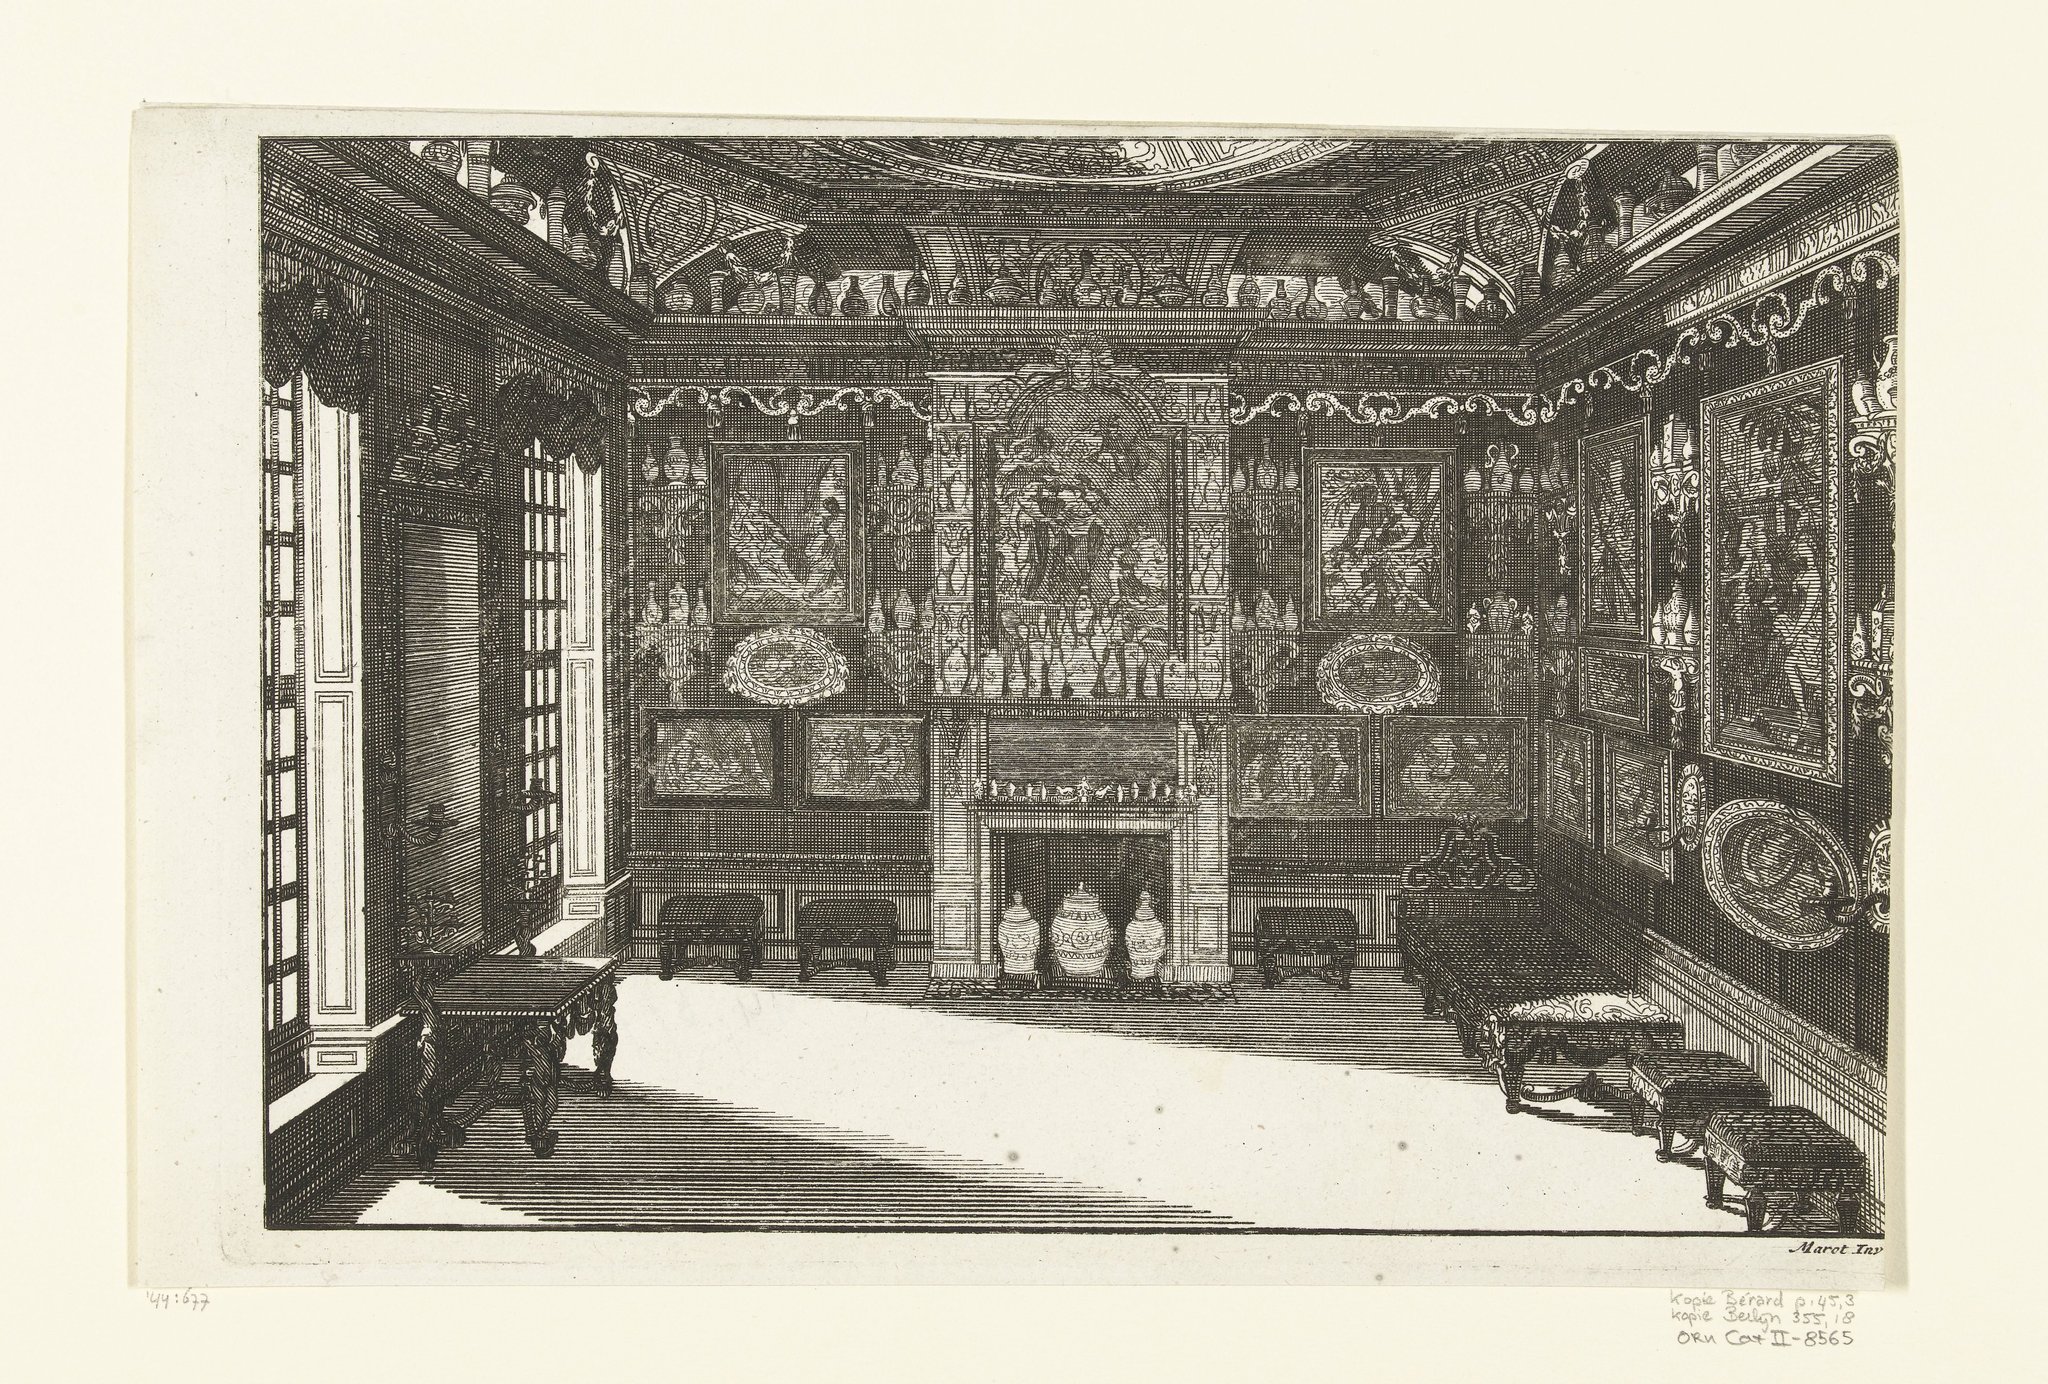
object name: print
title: Interieurs en borduurvoorbeelden voor delen van bedden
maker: Anonymous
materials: paper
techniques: etching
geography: netherlands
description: Tegenzijdige kopie naar blad uit de serie Nouveaux Livre da Partements.